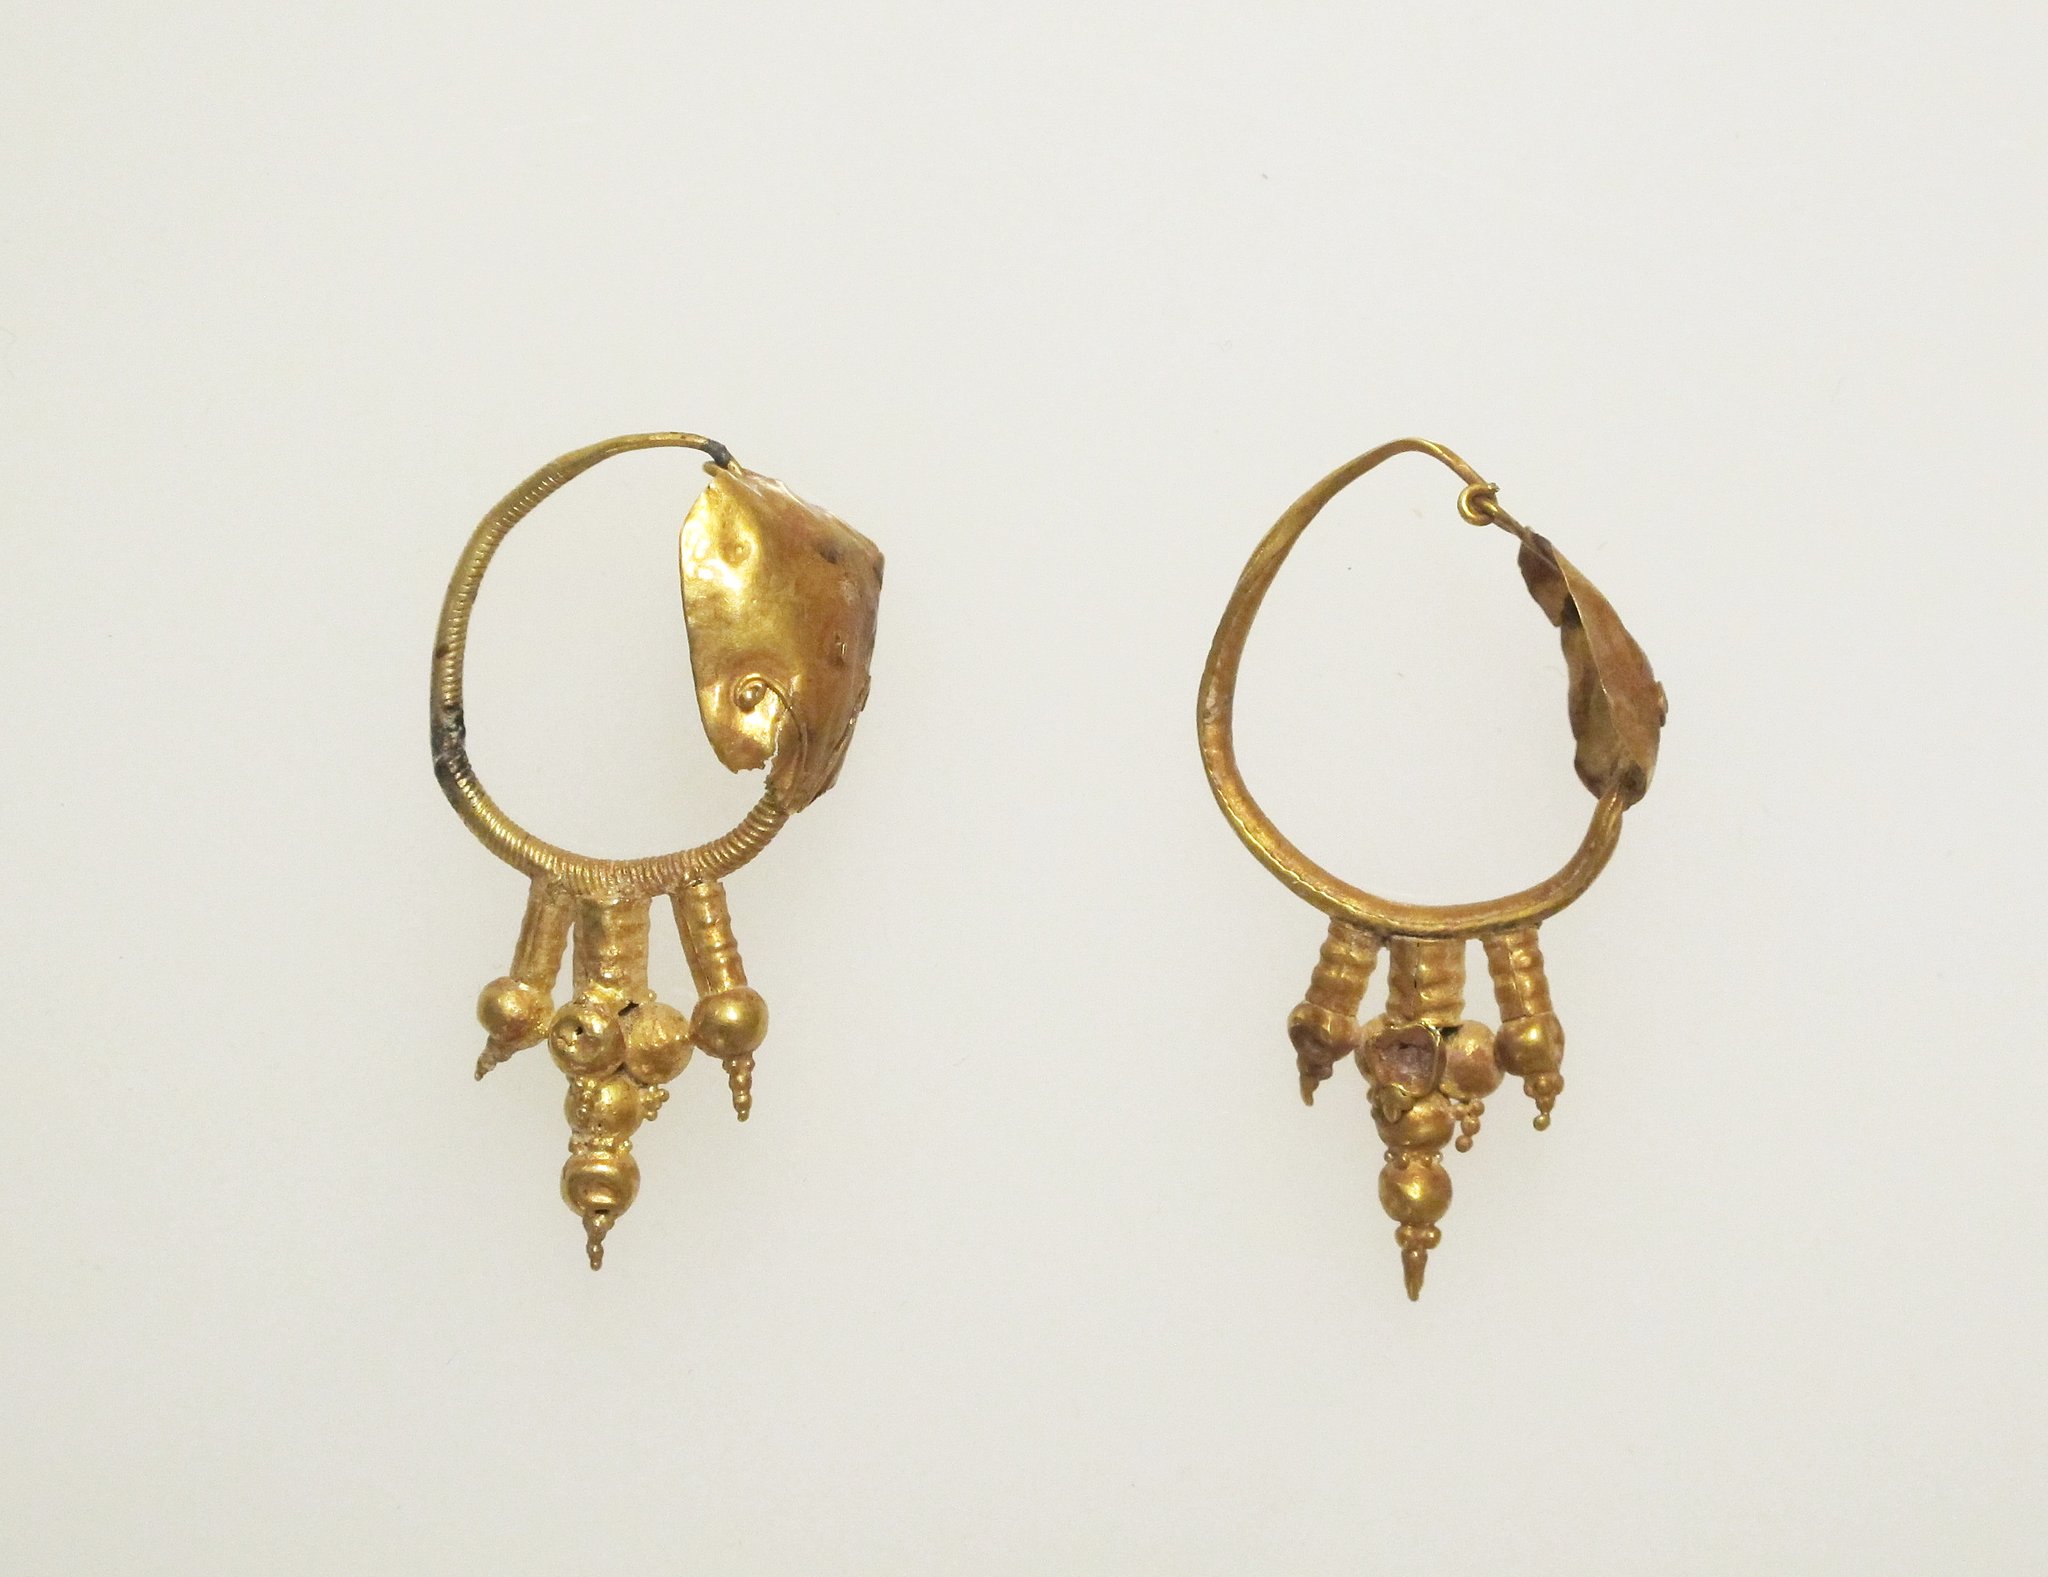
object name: earring with disc and pyramid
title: Earring with discs and pyramids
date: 7000 BCE-330 CE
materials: gold